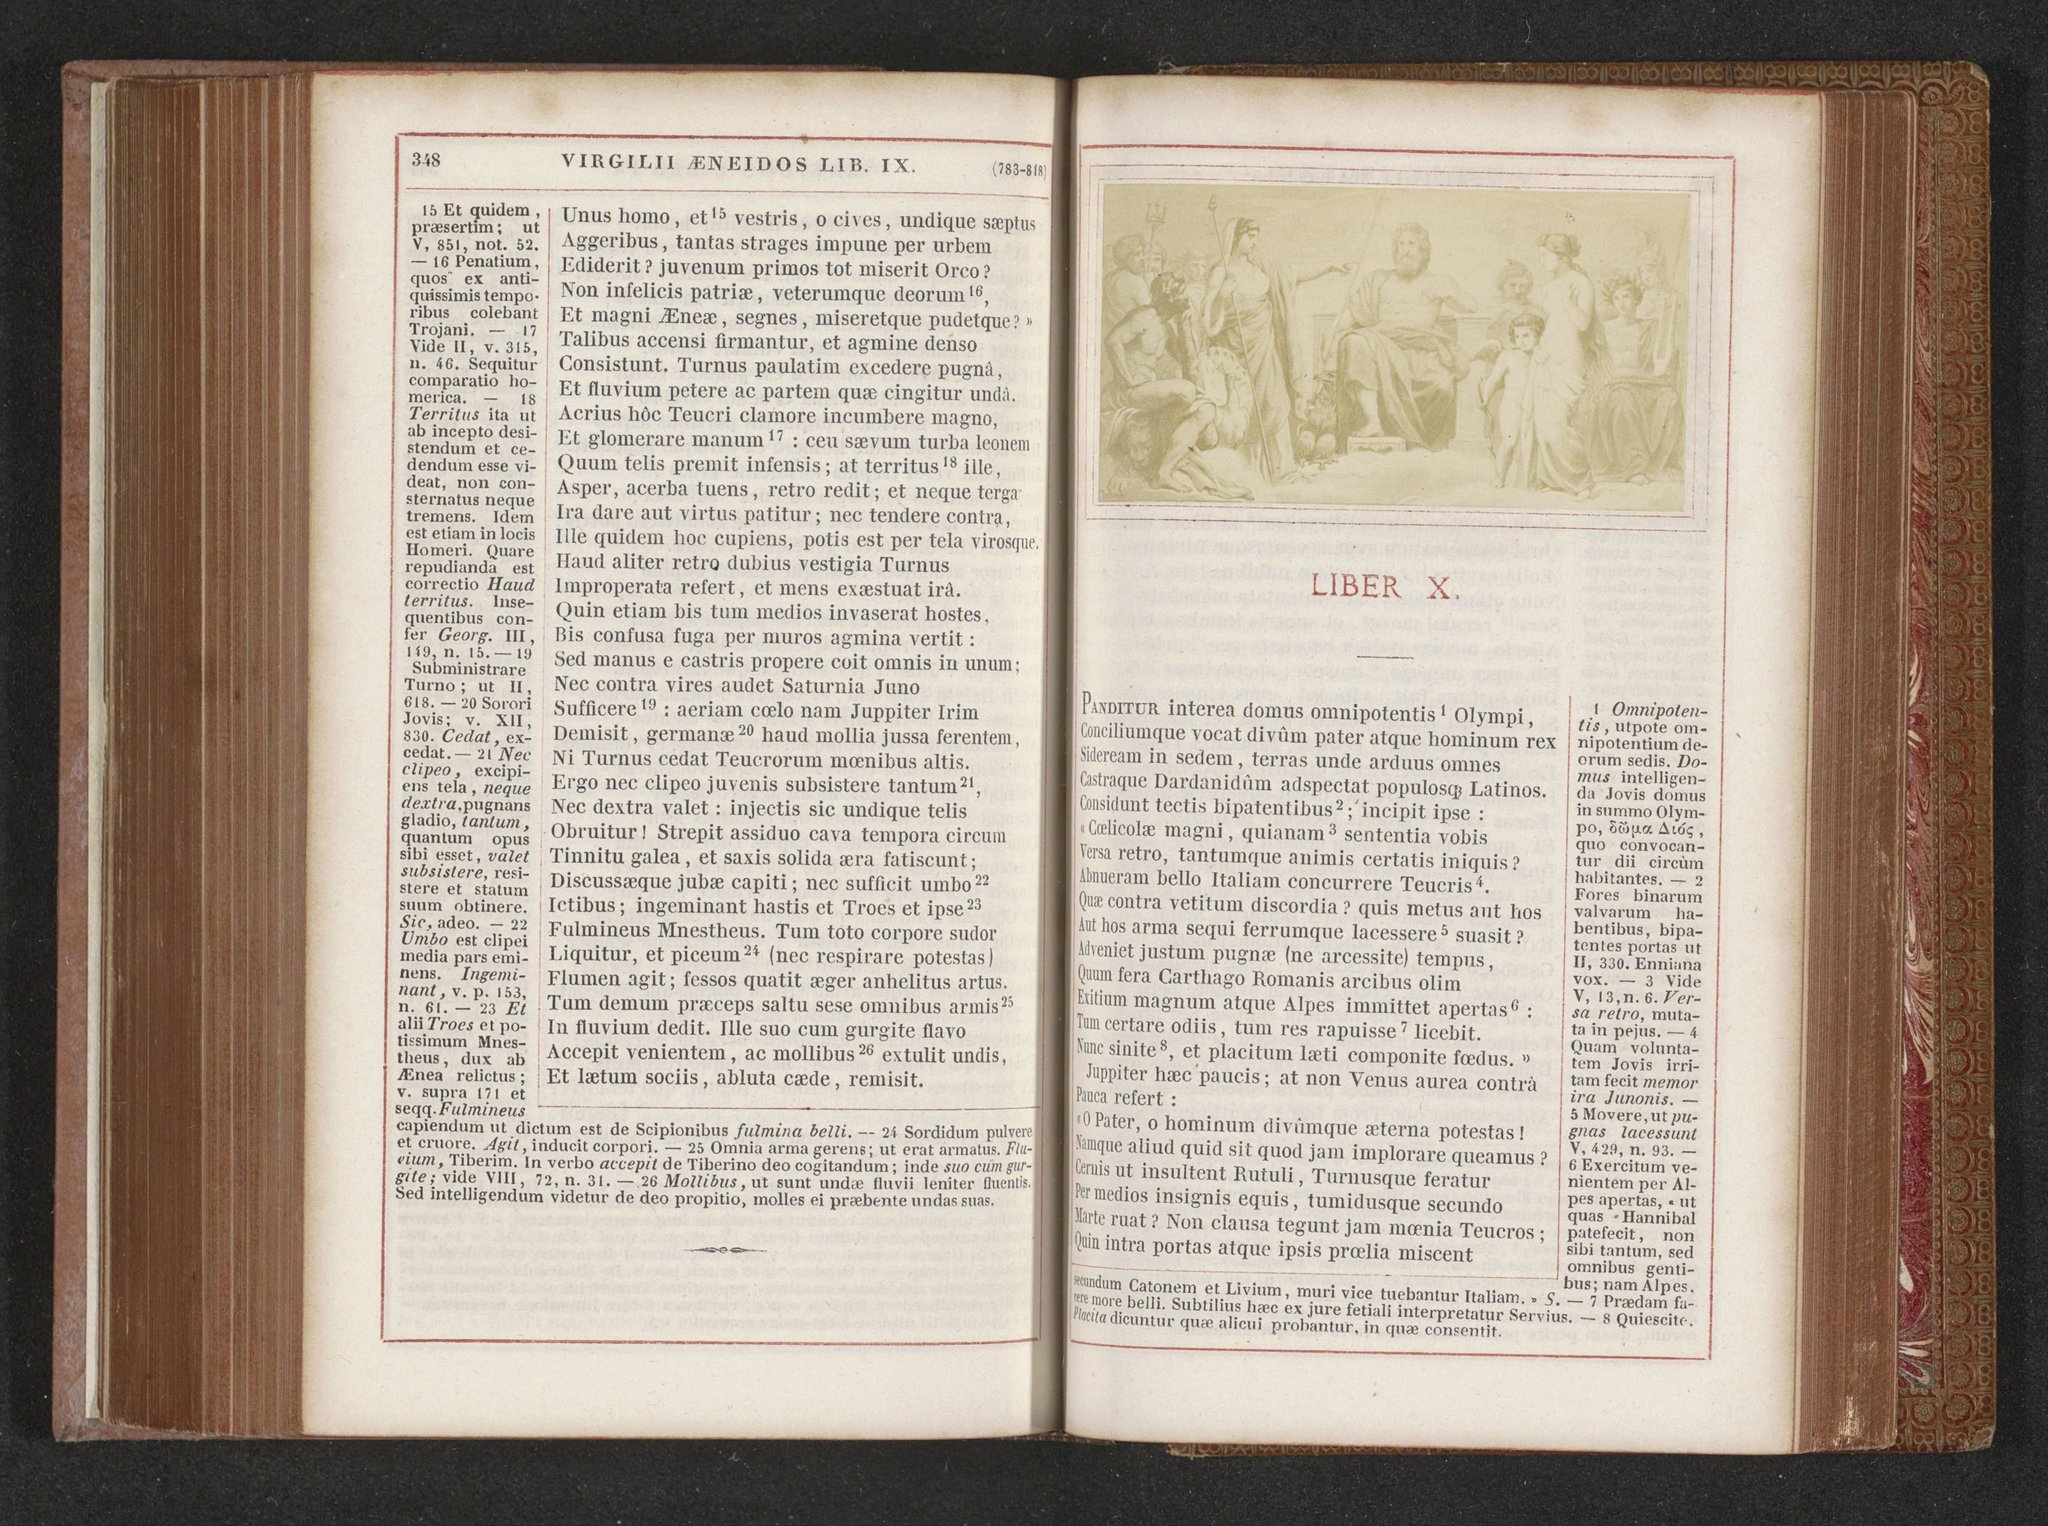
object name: page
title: Fotoreproductie van een schilderij, voorstellende een samenkomst van de Griekse goden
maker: Anonymous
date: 1850-1858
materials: photographic support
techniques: albumen print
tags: assembly of the gods ~ aeneas' return to the battle of latium